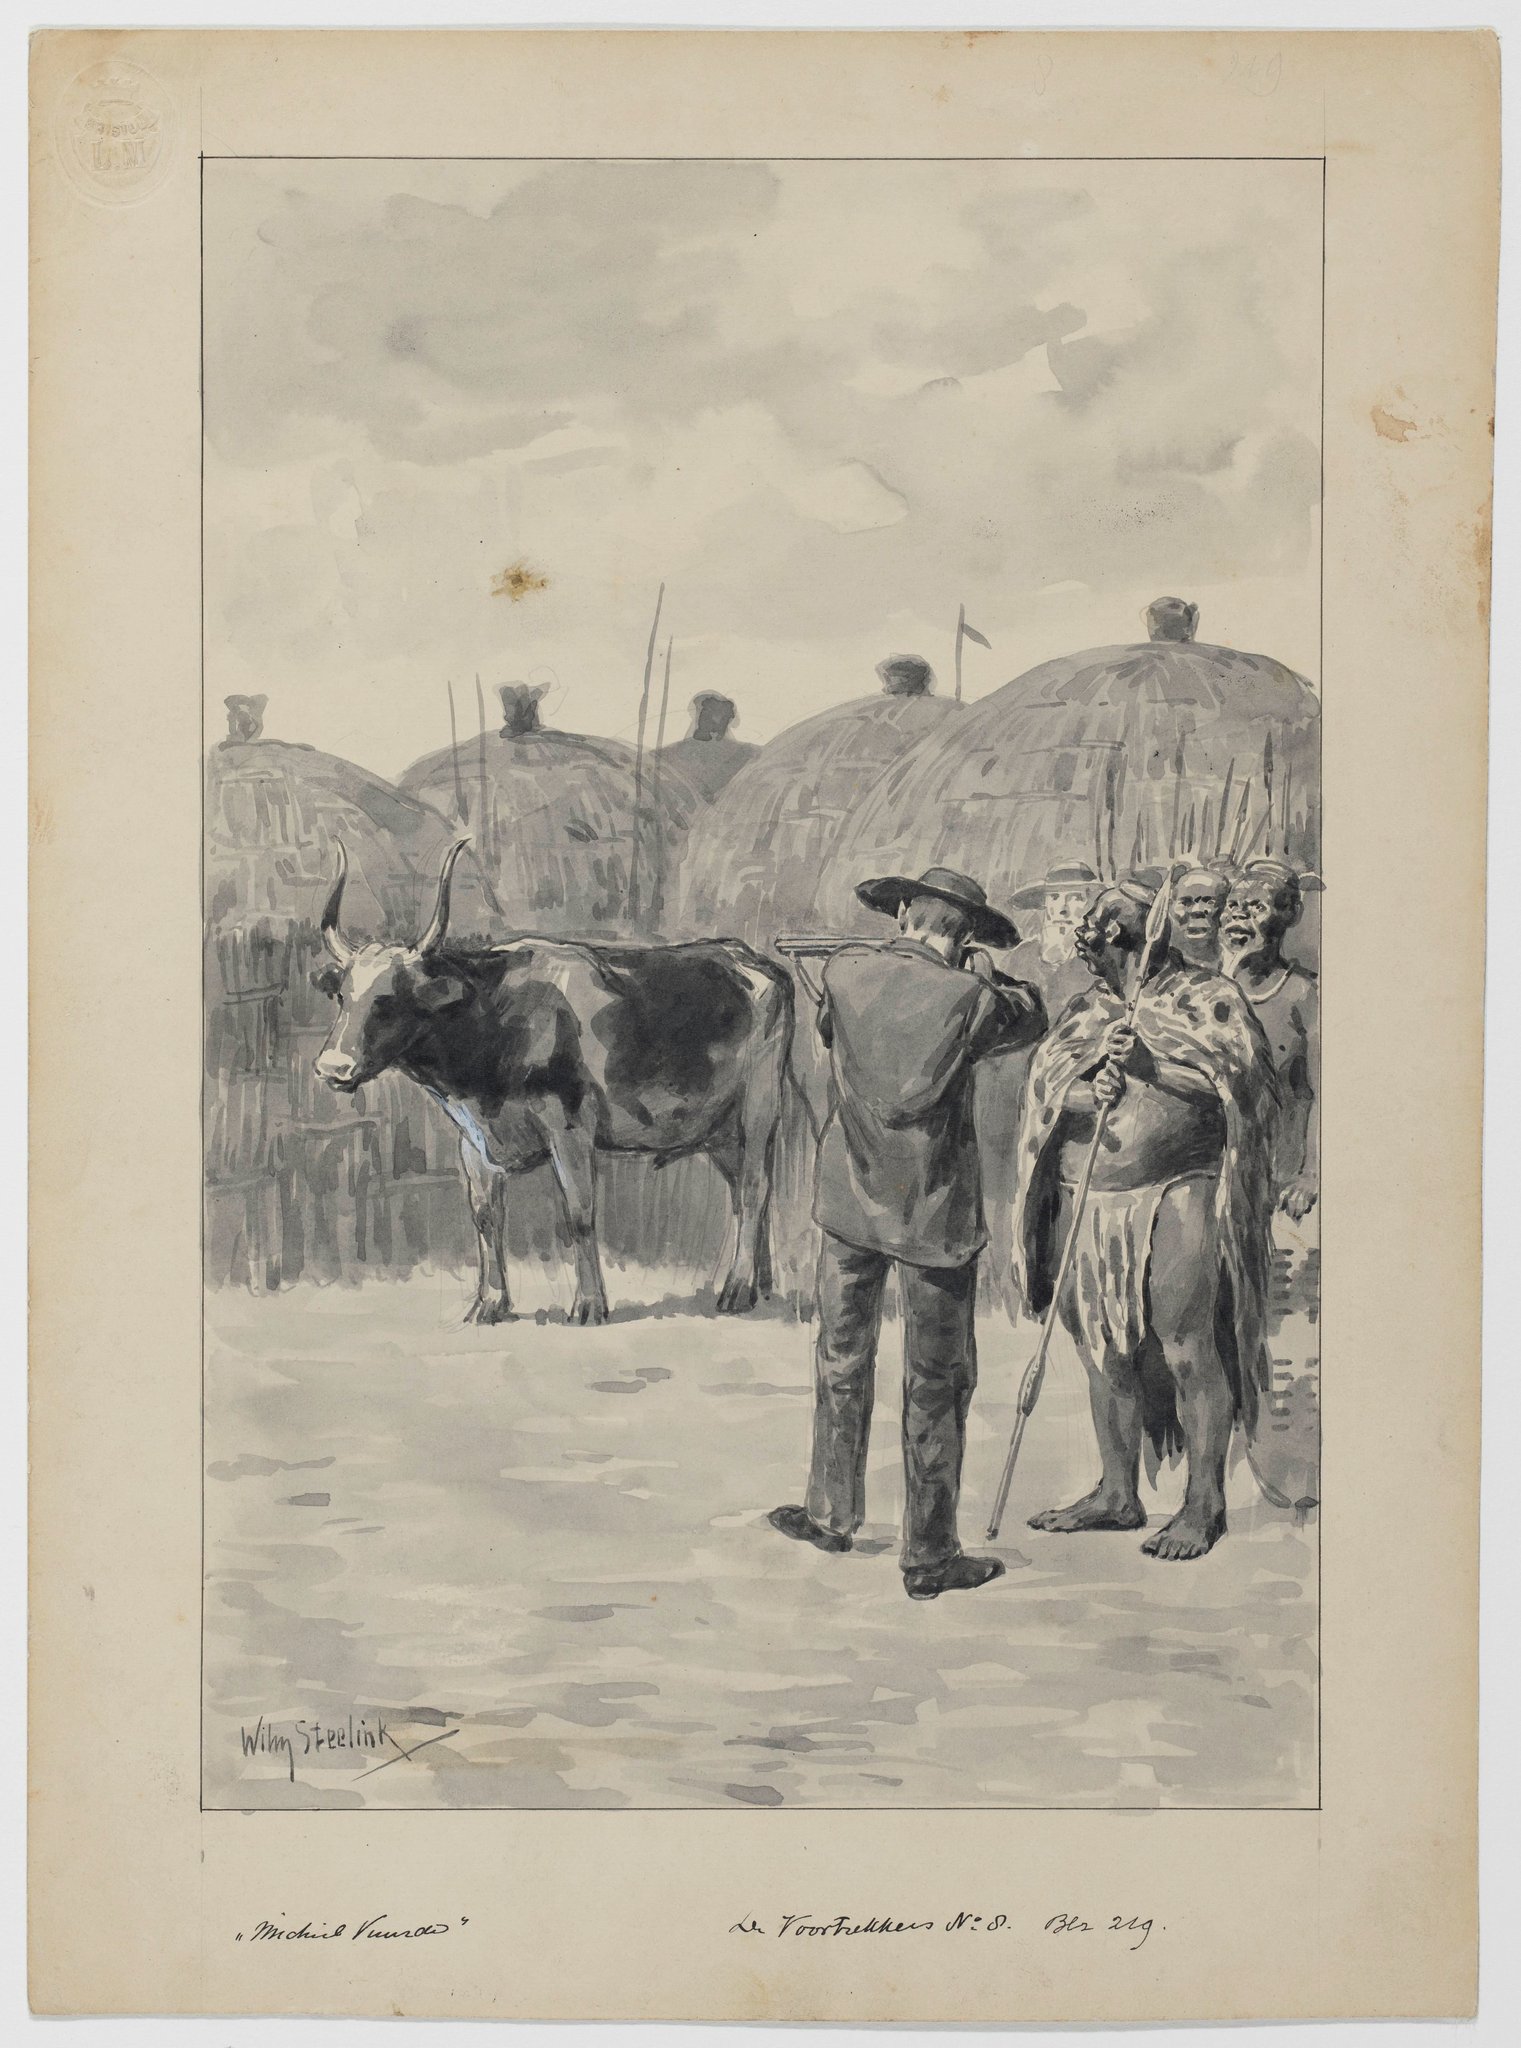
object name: design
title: Michiel vuurde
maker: willem steelink (i)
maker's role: draughtsman, print maker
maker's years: 1826-1913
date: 1836-1913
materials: paper, pencil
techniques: brush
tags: sharpshooting with rifle, shotgun or other long firearms (~ games of skill), africans, illustration ~ printed matter, book, ox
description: Ontwerp voor een illustratie in De Voortrekkers, of Het Dagboek van Izak van der Merwe, door J.D. Kestell en N. Hofmeijer.